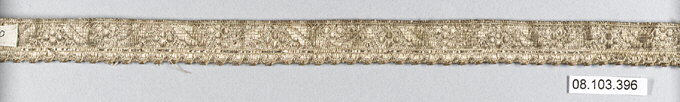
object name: galloon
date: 1601-1800